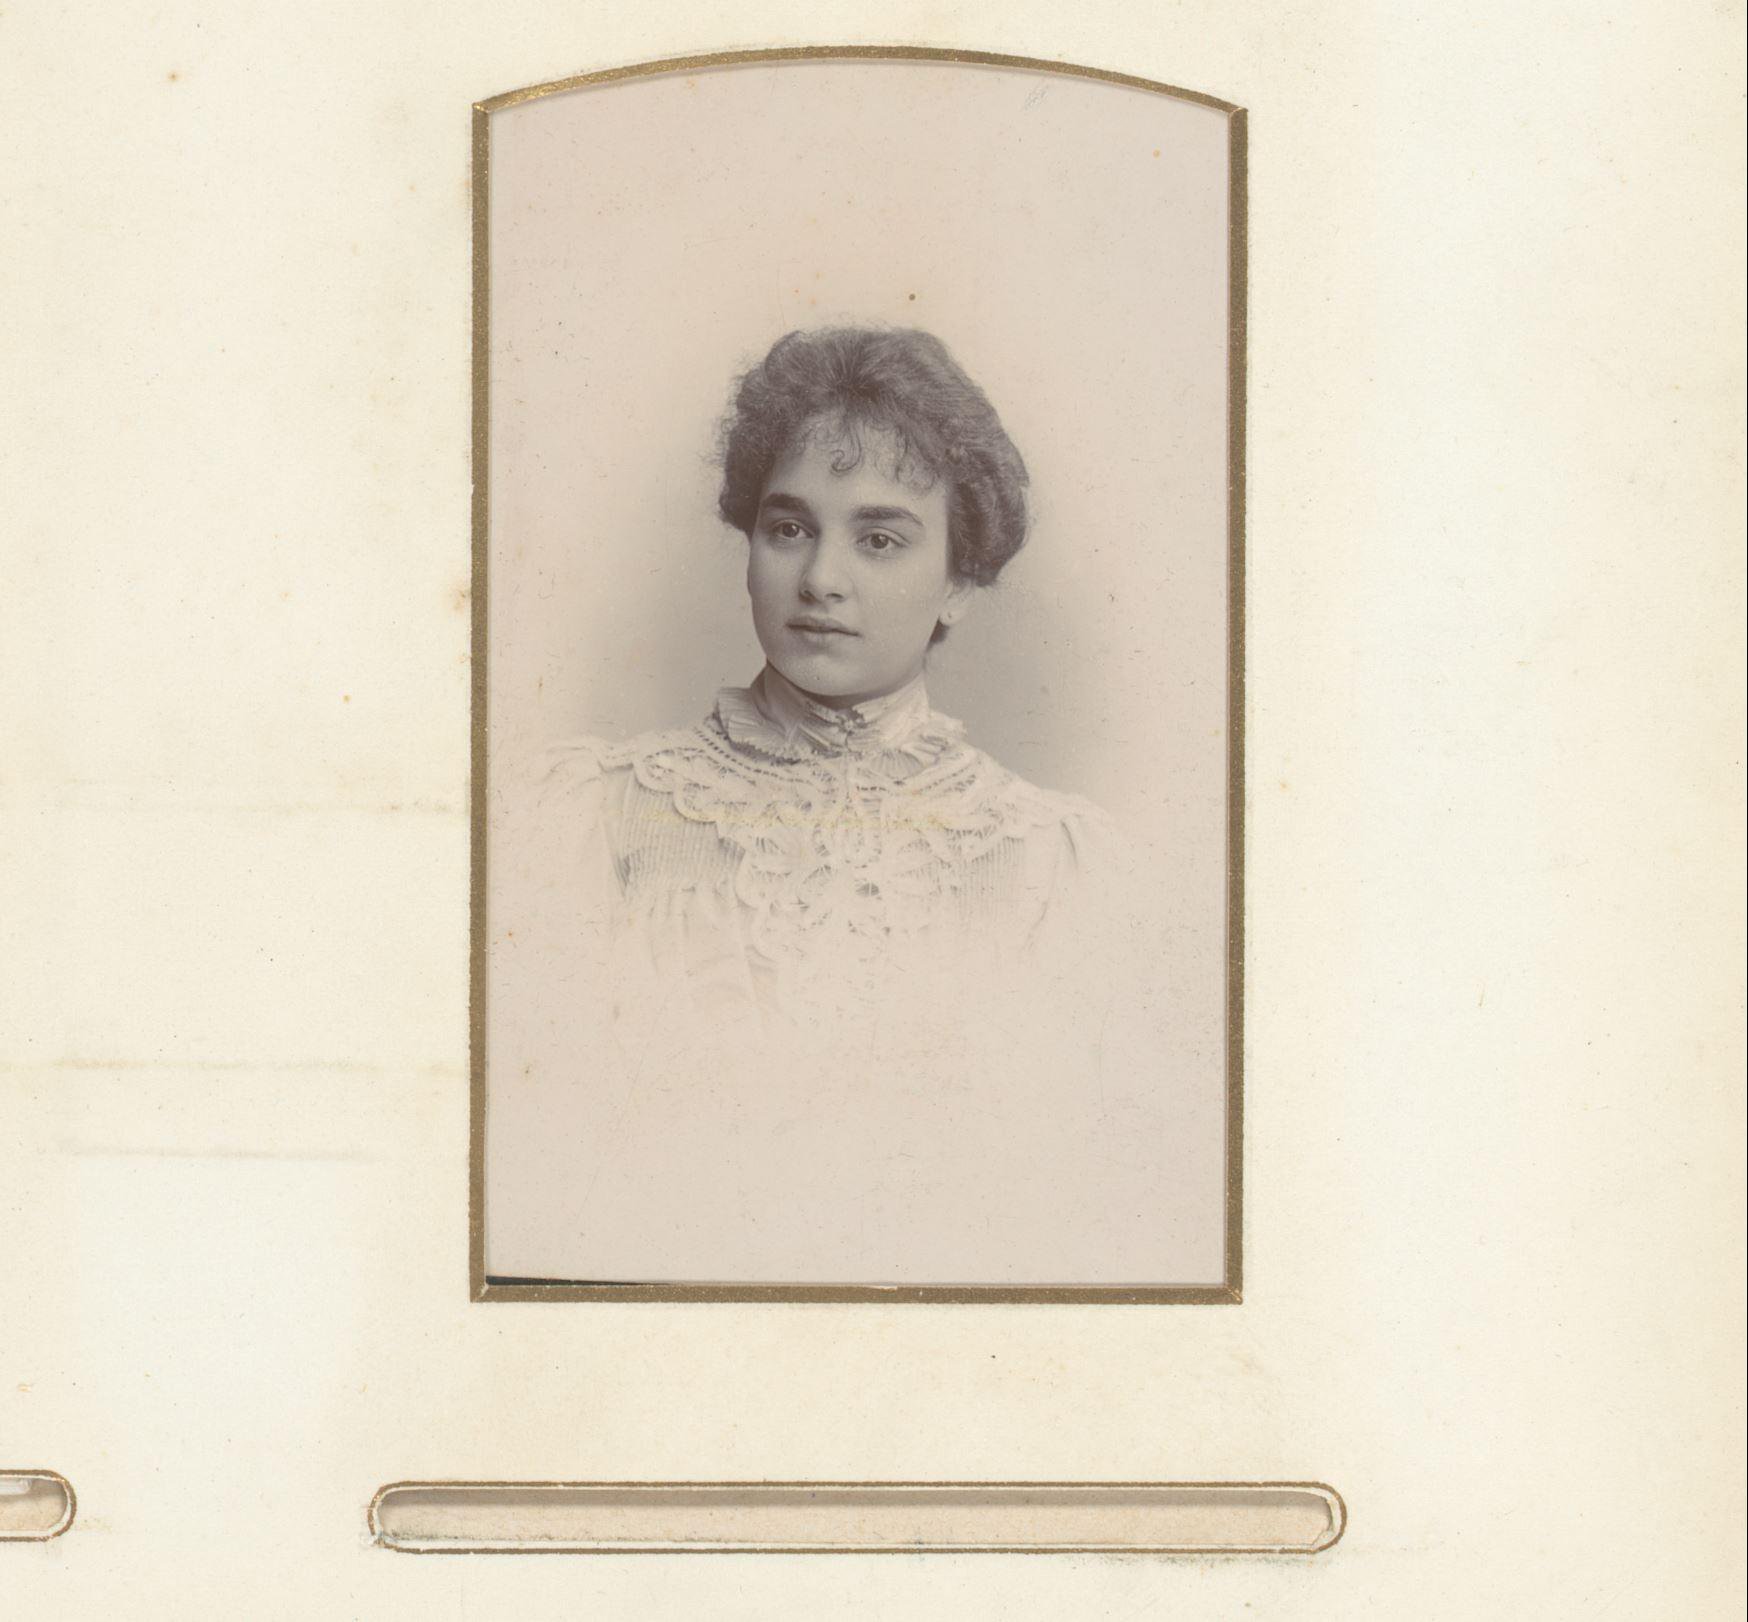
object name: photograph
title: Portret van een vrouw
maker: h.l. laurence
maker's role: fotograaf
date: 1880-1940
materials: cardboard, photographic support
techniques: collodion silver print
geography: london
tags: historical persons - bb - woman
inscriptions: inscription: ‘H.L. Laurence/ 19. MELBOURNE GROVE/ EAST DULWICH, S.E.’, annotation: ‘with Mary's/ love’